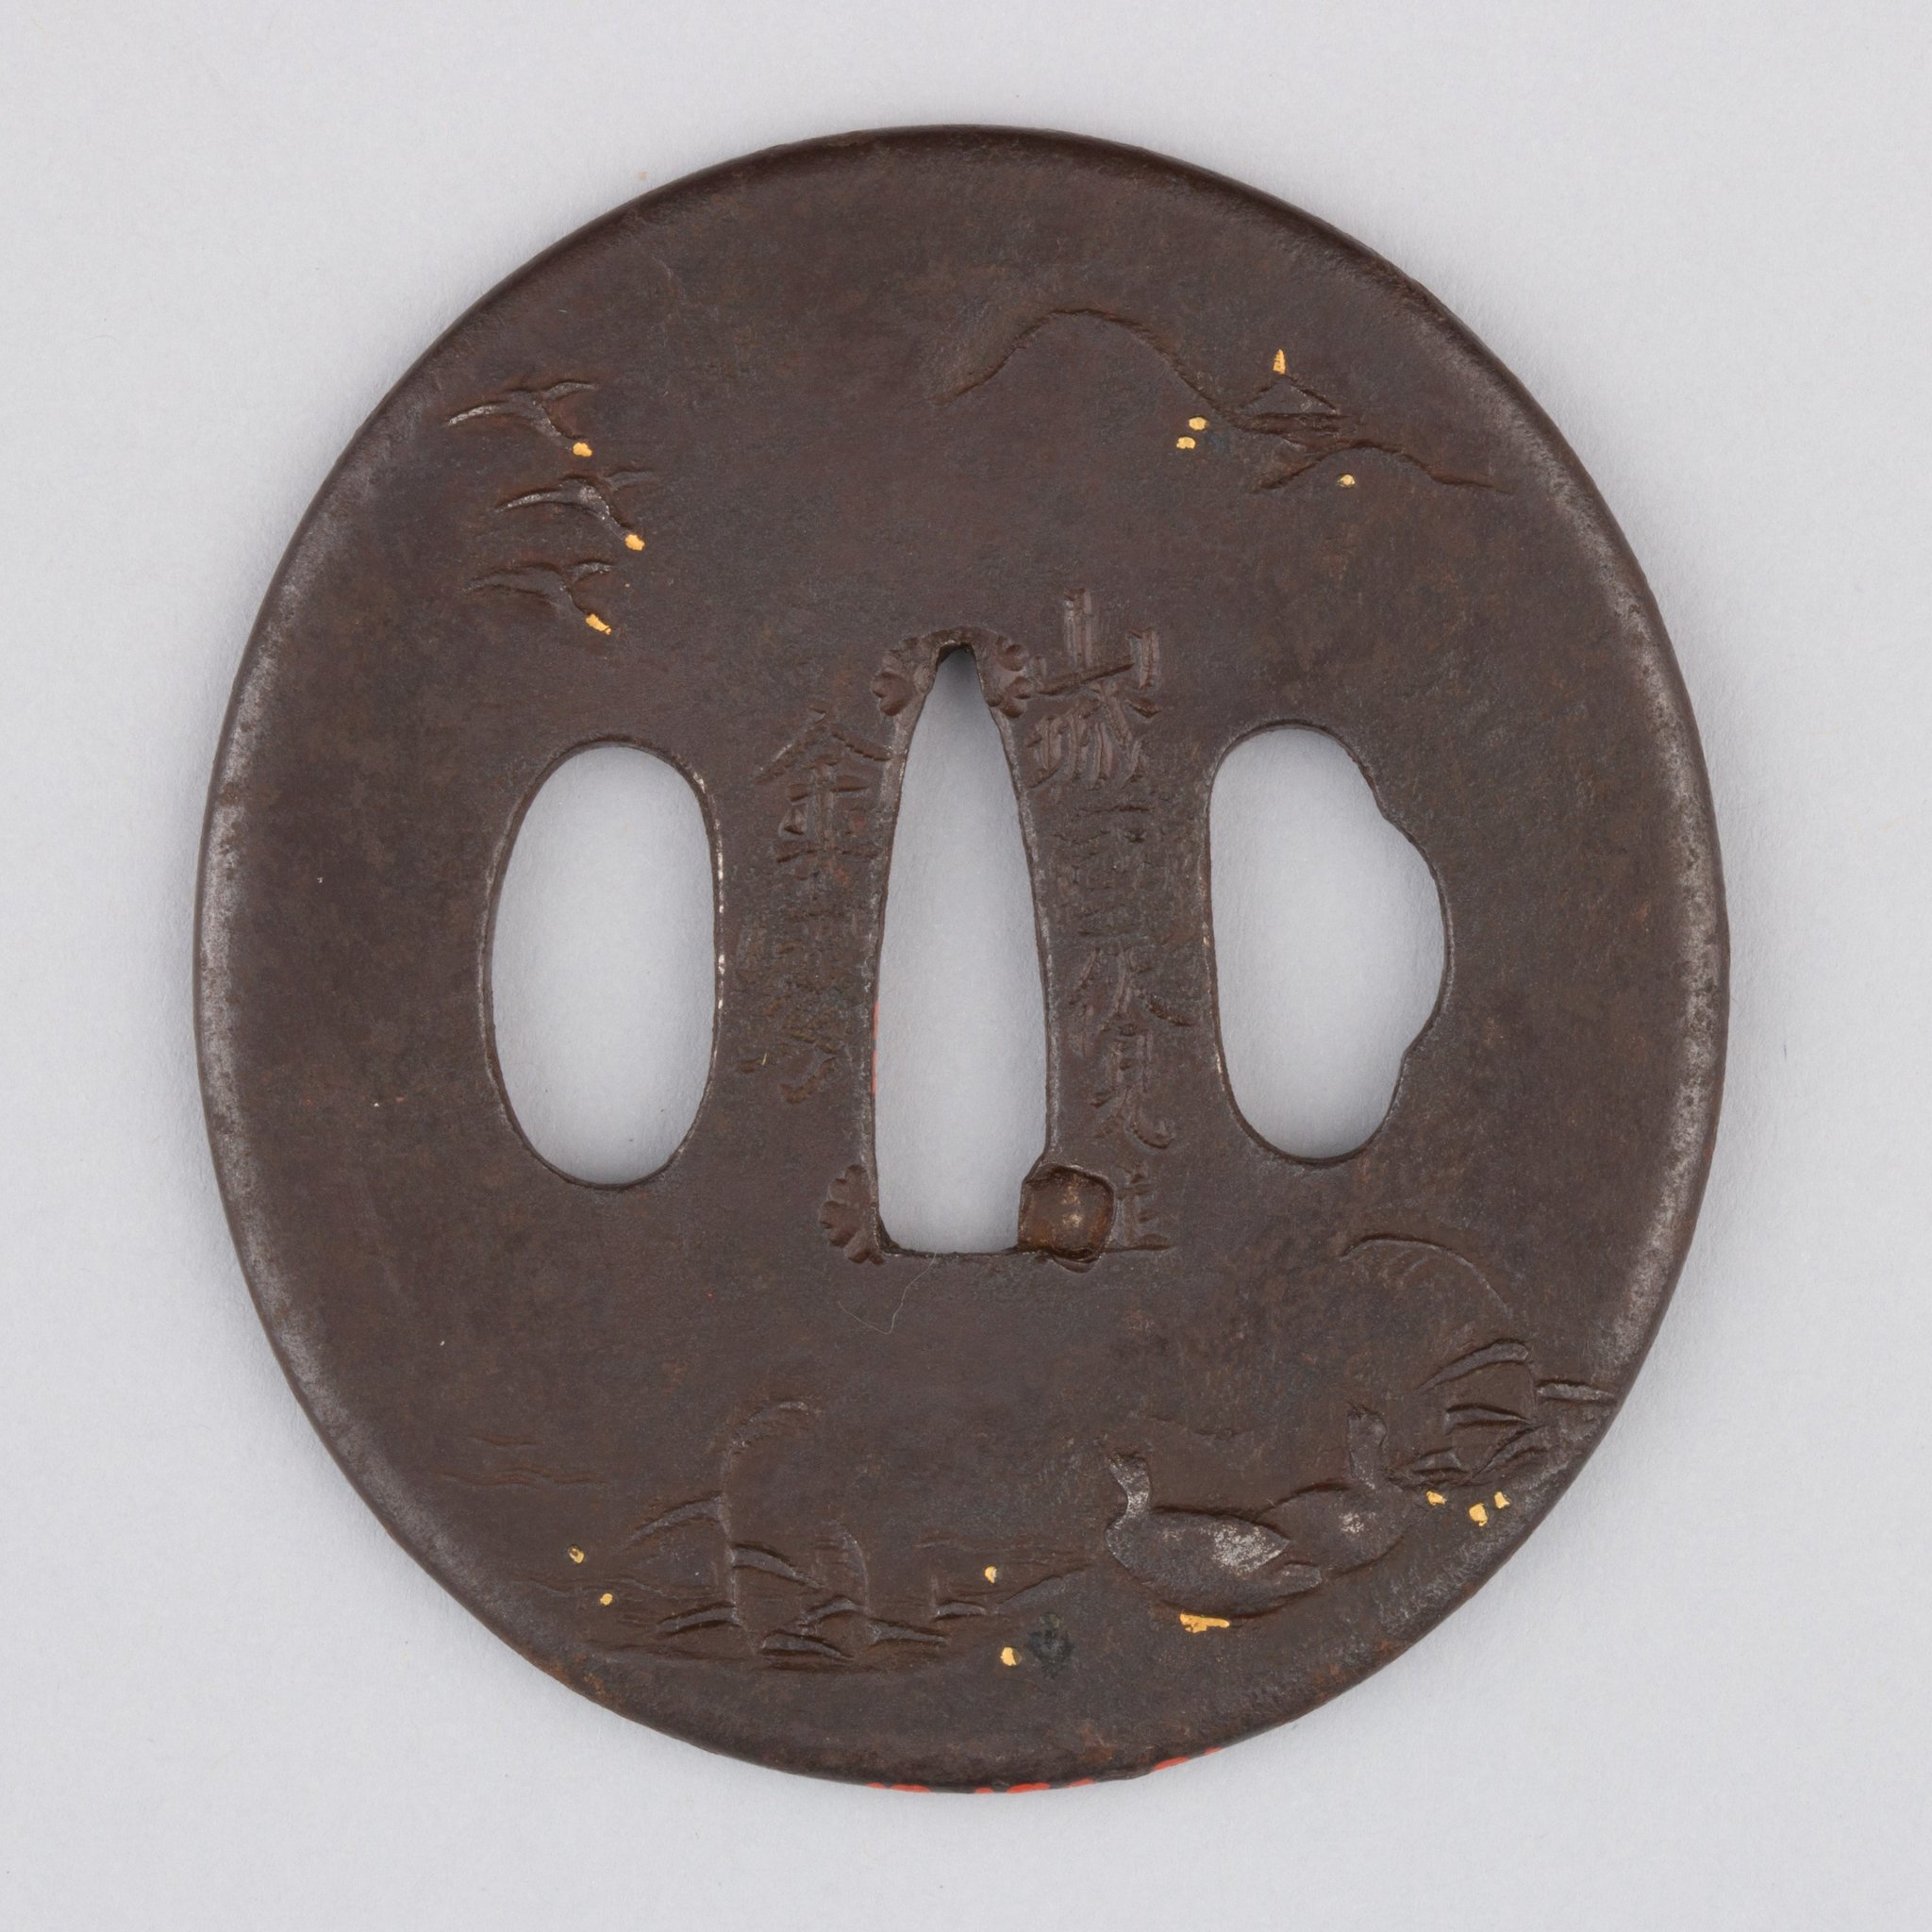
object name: sword guard tsuba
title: Sword Guard (Tsuba)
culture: japanese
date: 1615-1868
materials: copper, iron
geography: japan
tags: ducks,mountains